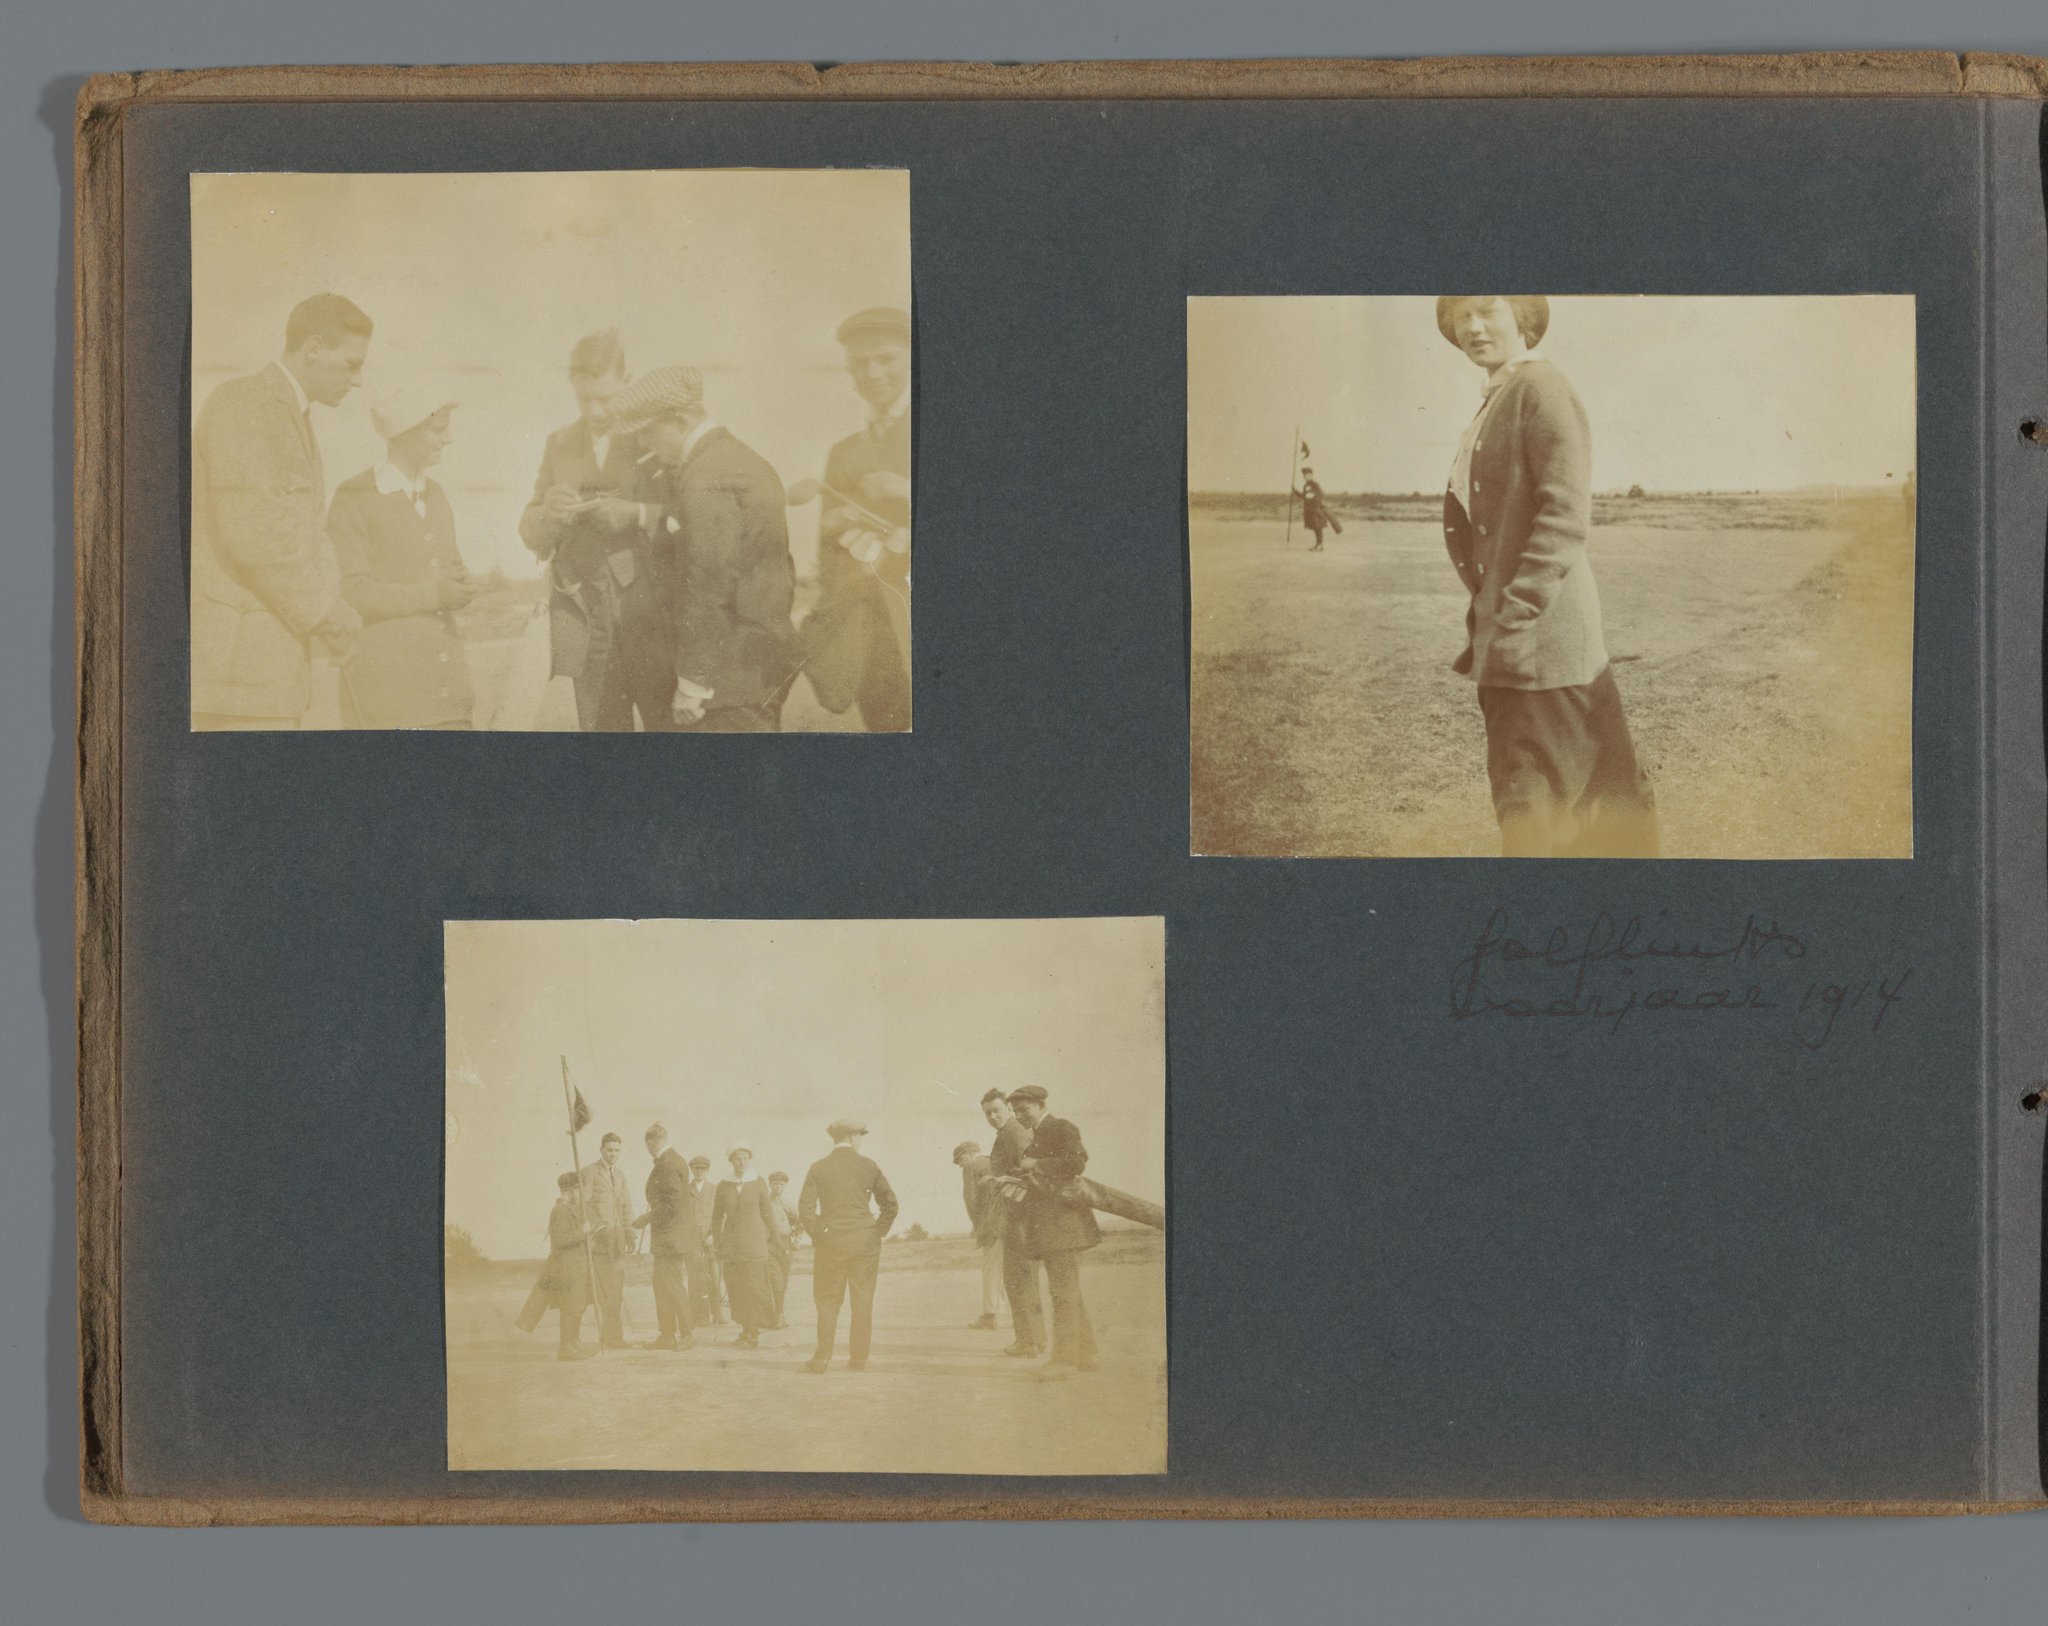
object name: photograph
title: Vriendengroep op een golfbaan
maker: carolina frederika onnen (lien/loen)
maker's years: 1896-1983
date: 1914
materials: paper, cardboard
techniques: gelatin silver print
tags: golf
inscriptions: inscription: ‘Golfli[...]/ voorjaar 1914’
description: Deze foto's zijn onderdeel van een album.